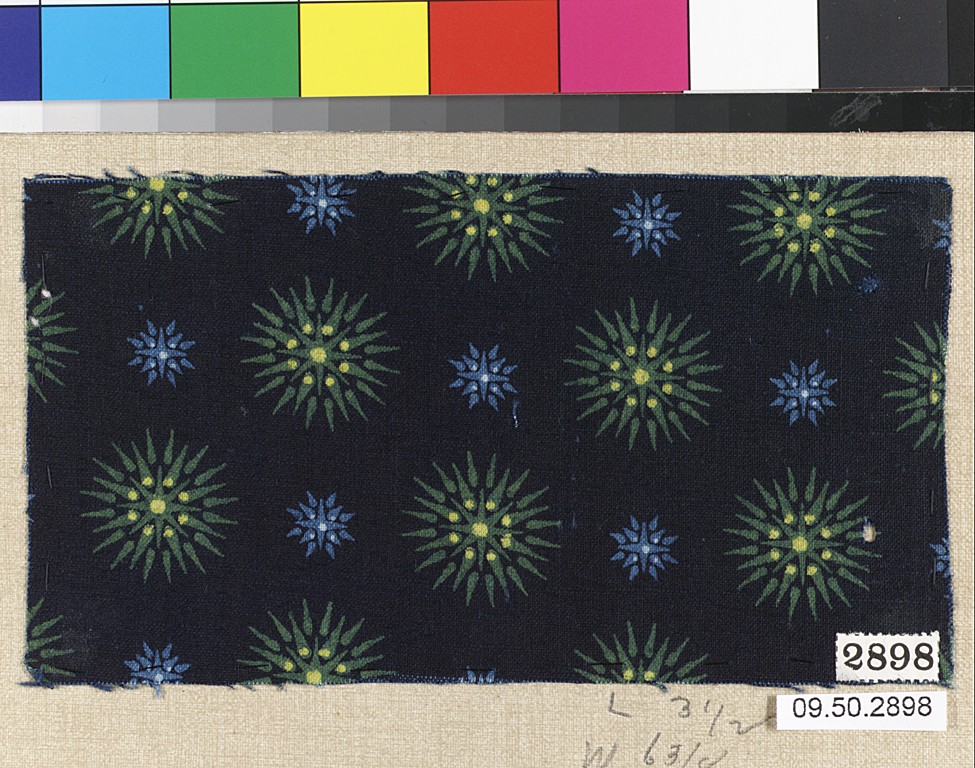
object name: piece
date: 1801-1900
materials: cotton